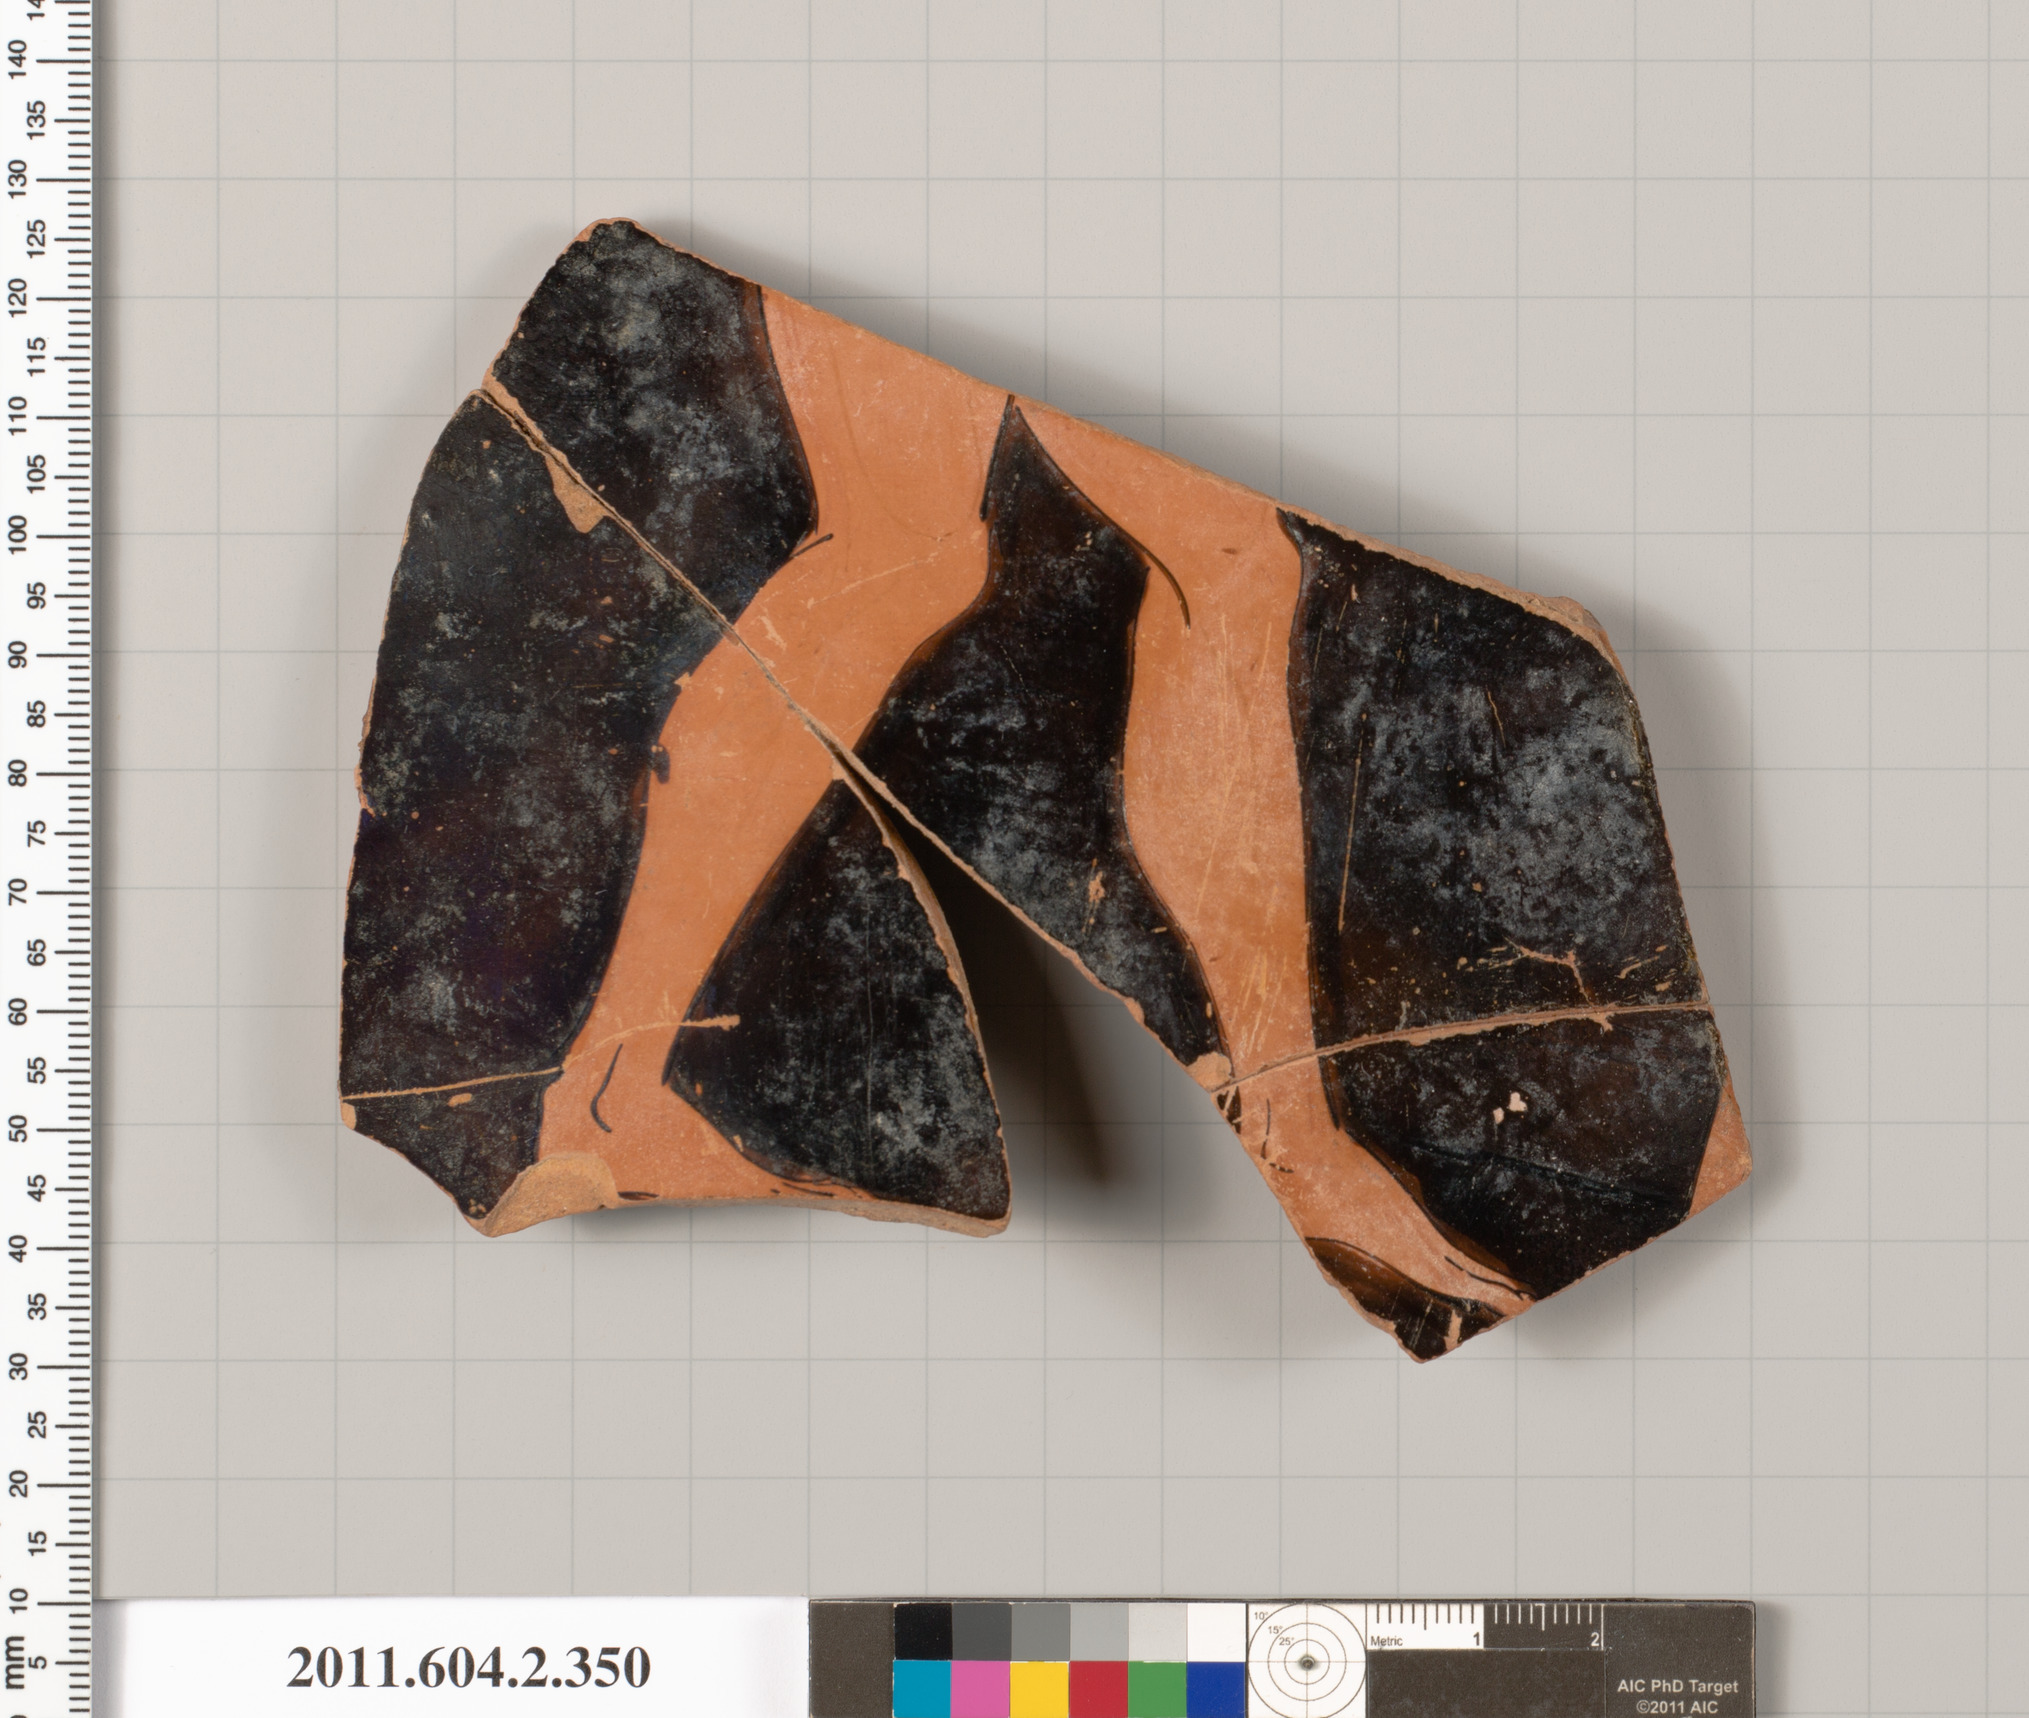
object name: column krater fragment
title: Terracotta fragment of a column-krater (bowl for mixing wine and water)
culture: greek, attic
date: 460-440 BCE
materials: terracotta